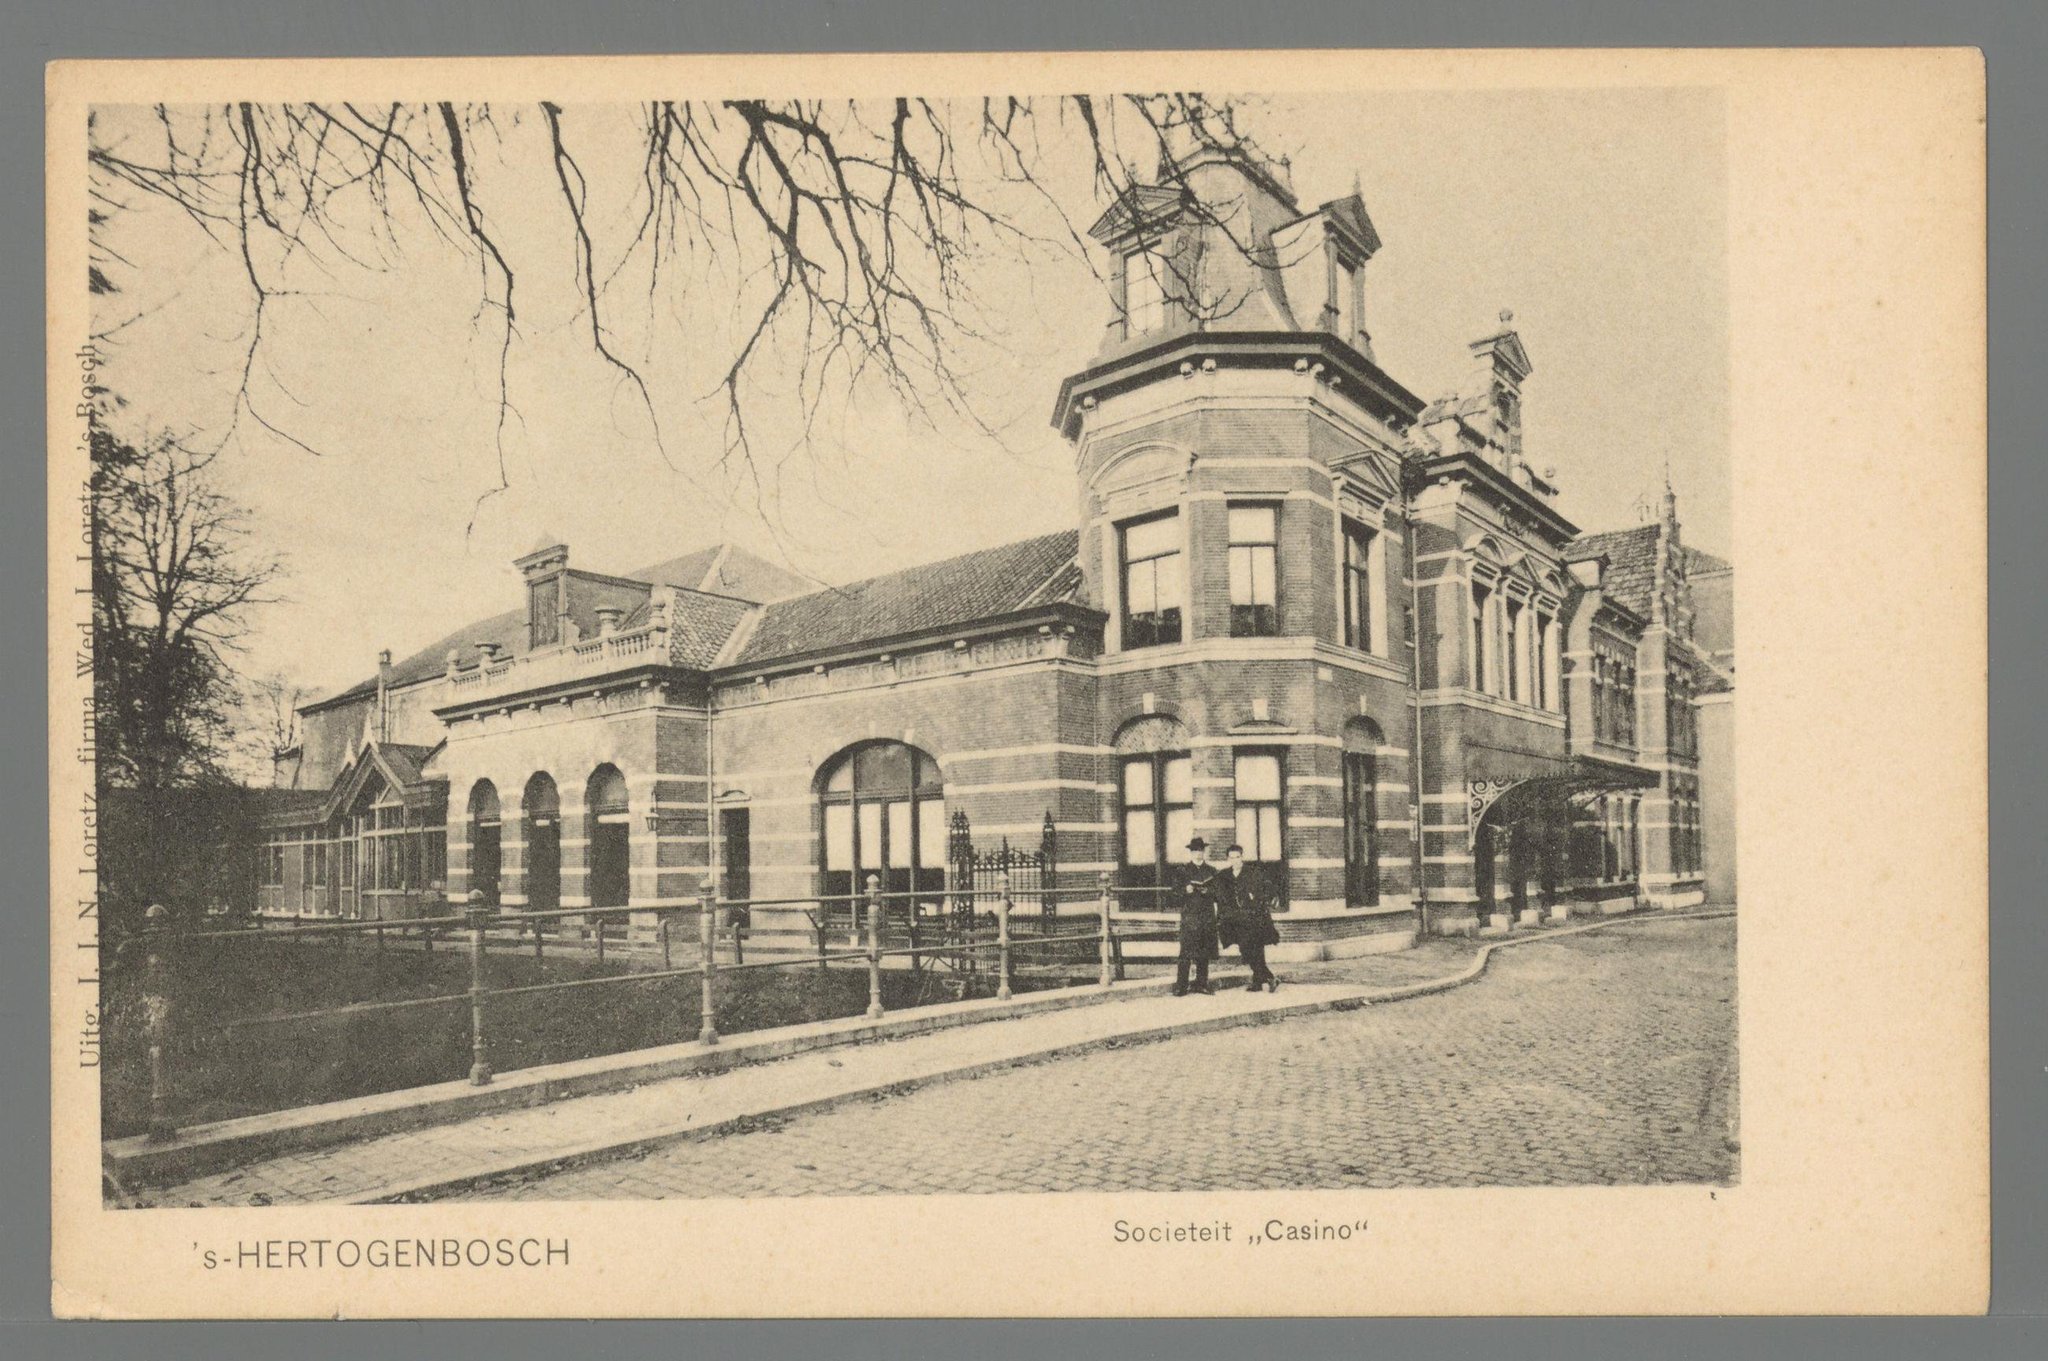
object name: ansichtkaart, prentbriefkaart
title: 's-Hertogenbosch. Societeit "Casino"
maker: Anonymous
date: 1900-1905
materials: cardboard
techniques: photograph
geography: den bosch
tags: club, meeting place, street, den bosch